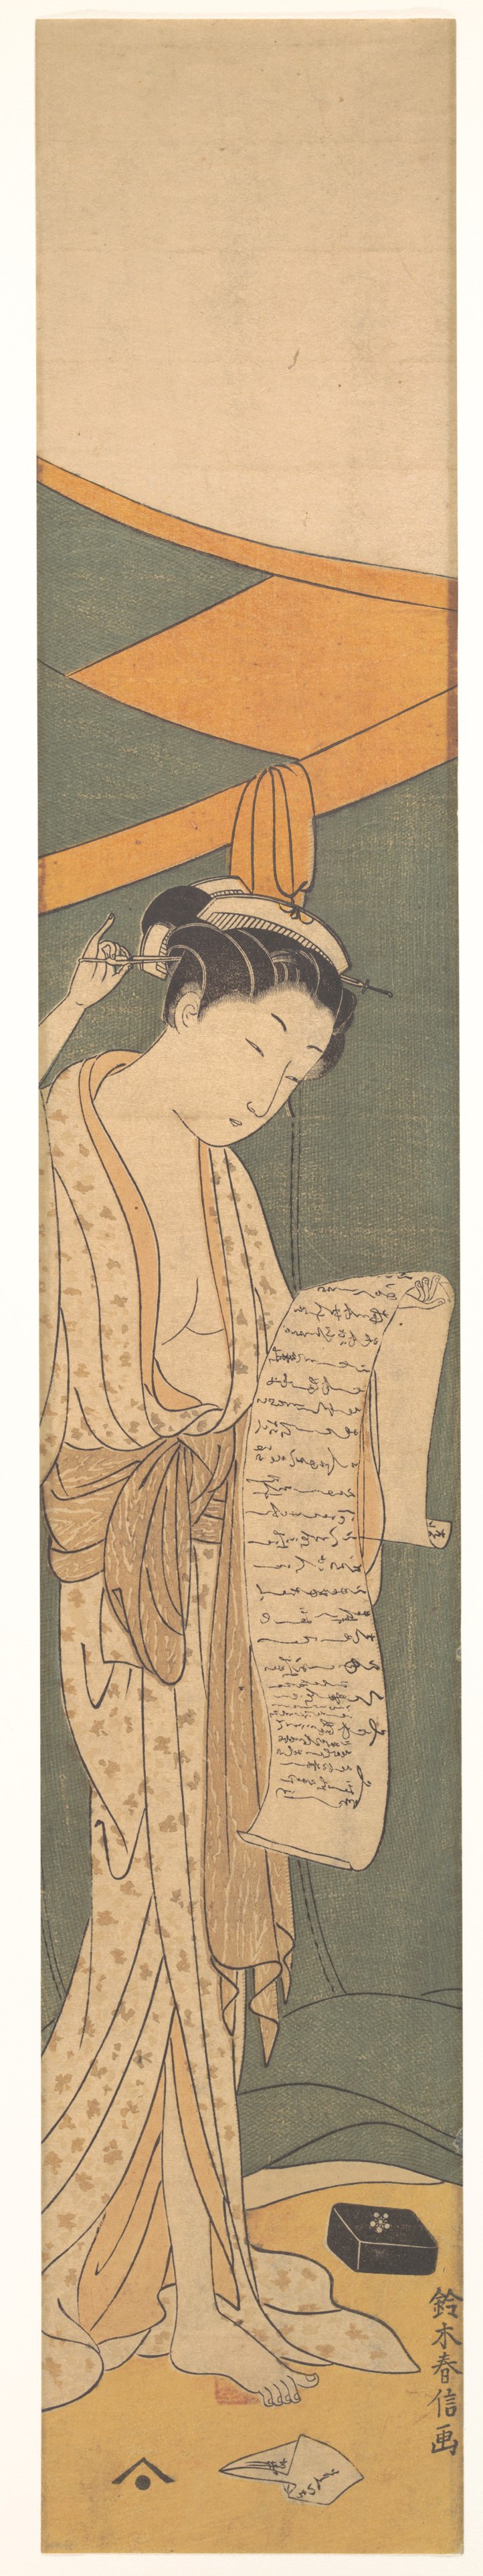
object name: woodblock print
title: Woman in Night Robe Reading a Letter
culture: japanese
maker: suzuki harunobu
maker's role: artist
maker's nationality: japanese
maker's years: 1725-1770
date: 1764-1772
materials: ink, paper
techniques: woodblock print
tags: women,reading